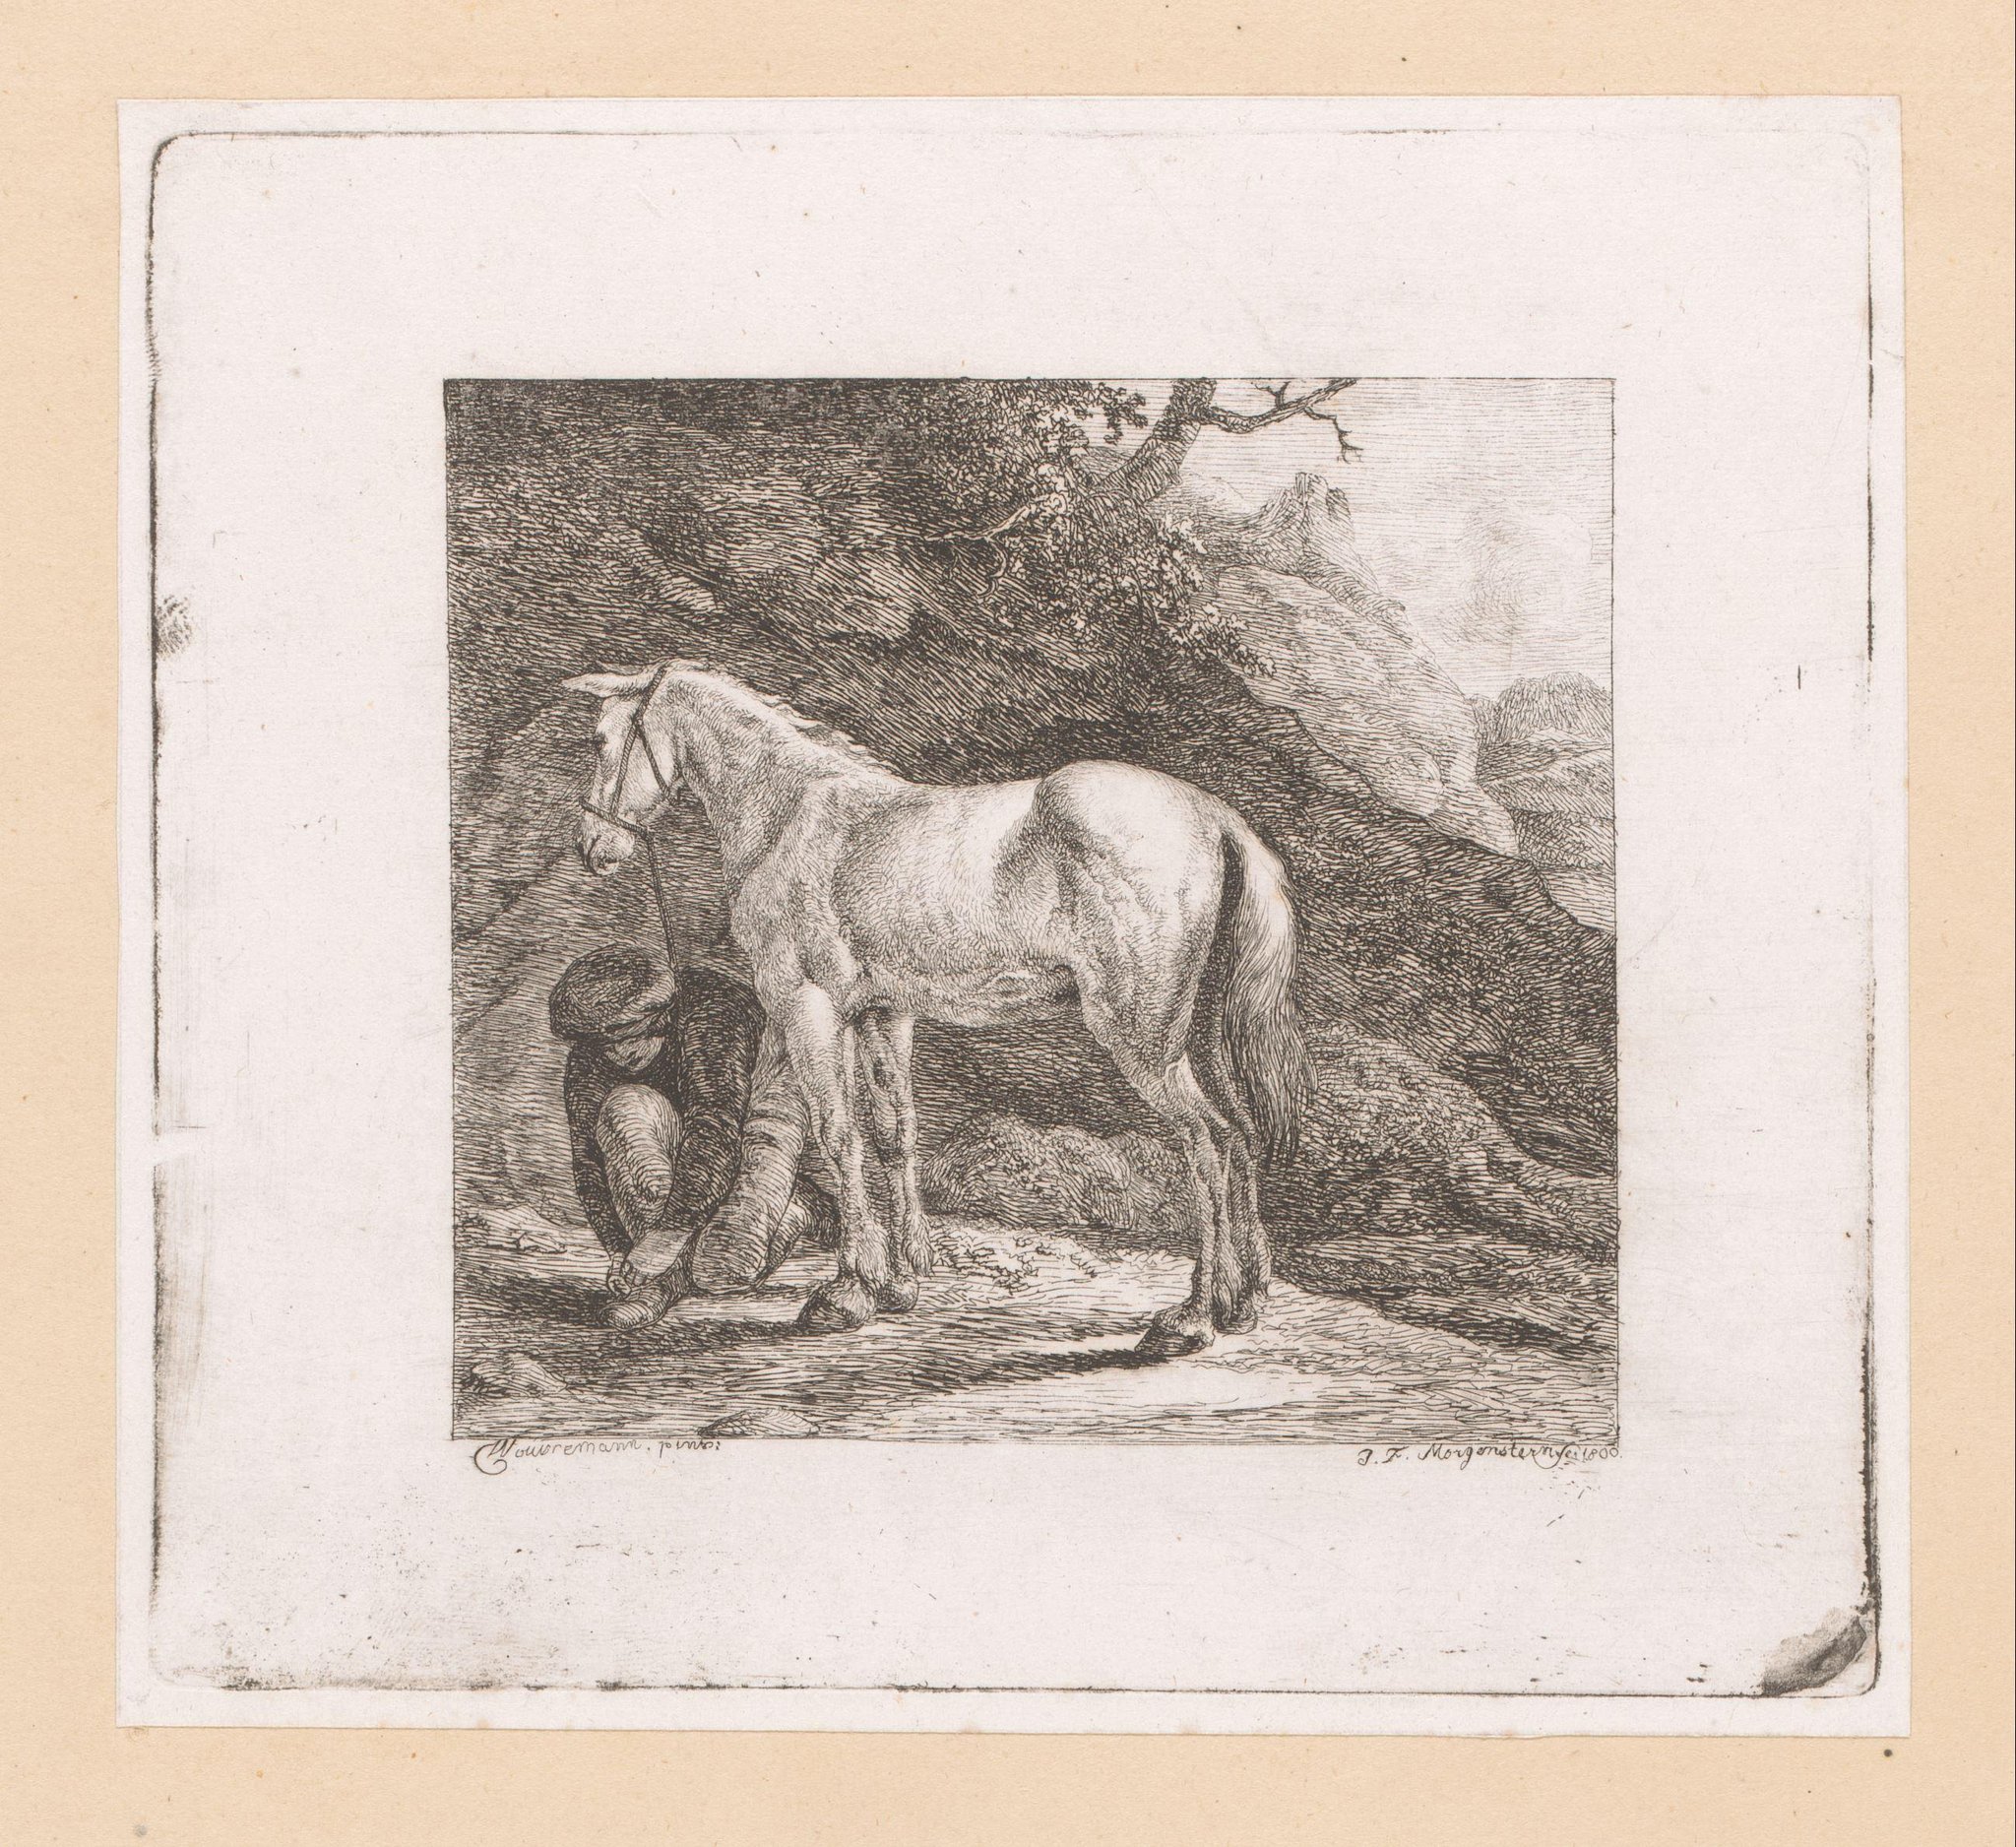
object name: print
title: Man met paard strikt zijn veters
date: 1800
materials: paper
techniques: etching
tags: riding a horse, ass, or mule; rider, horseman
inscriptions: collector's mark: Lugt 2228